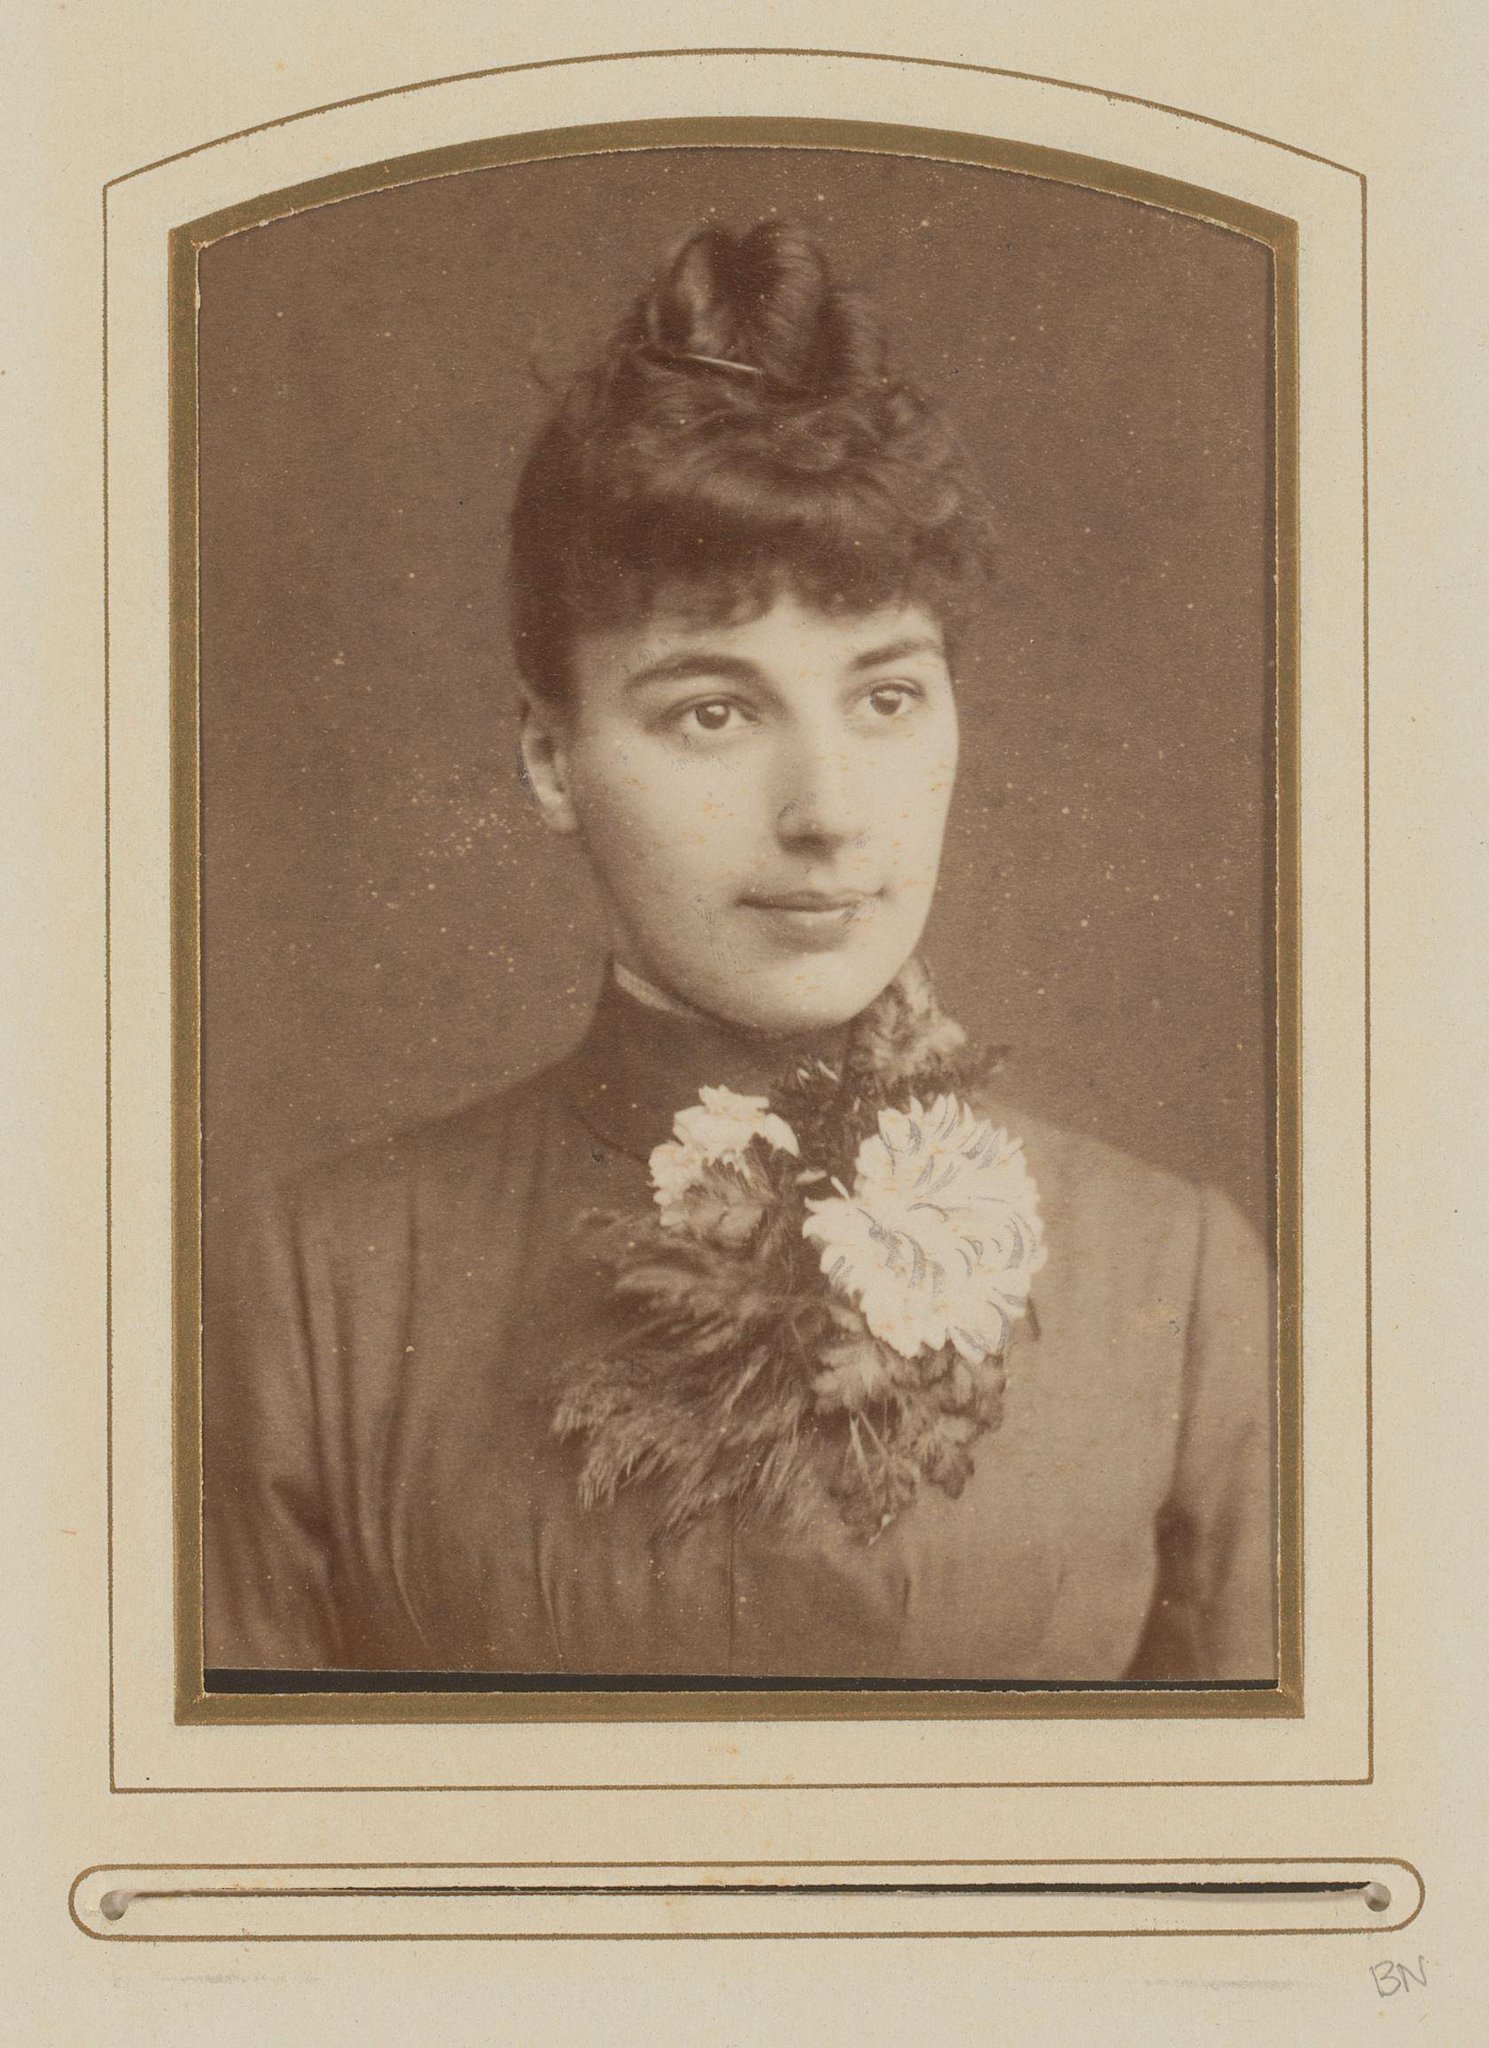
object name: cabinet photograph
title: Portret van een jonge vrouw met jurk met bloemen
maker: fr.c. lachenwitz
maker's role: fotograaf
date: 1875-1910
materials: cardboard, photographic support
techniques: albumen print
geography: cleves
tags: flowers, adolescent, young woman, maiden, historical persons - bb - woman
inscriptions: inscription: ‘FR. C. LACHENWITZ/ Atelier für Photographie/ BAD CLEVE/ Klosterstrasse 6/ in der Nähe des Brückthor's./ Die Platte bleibt zur Nachbestellung reservirt.’